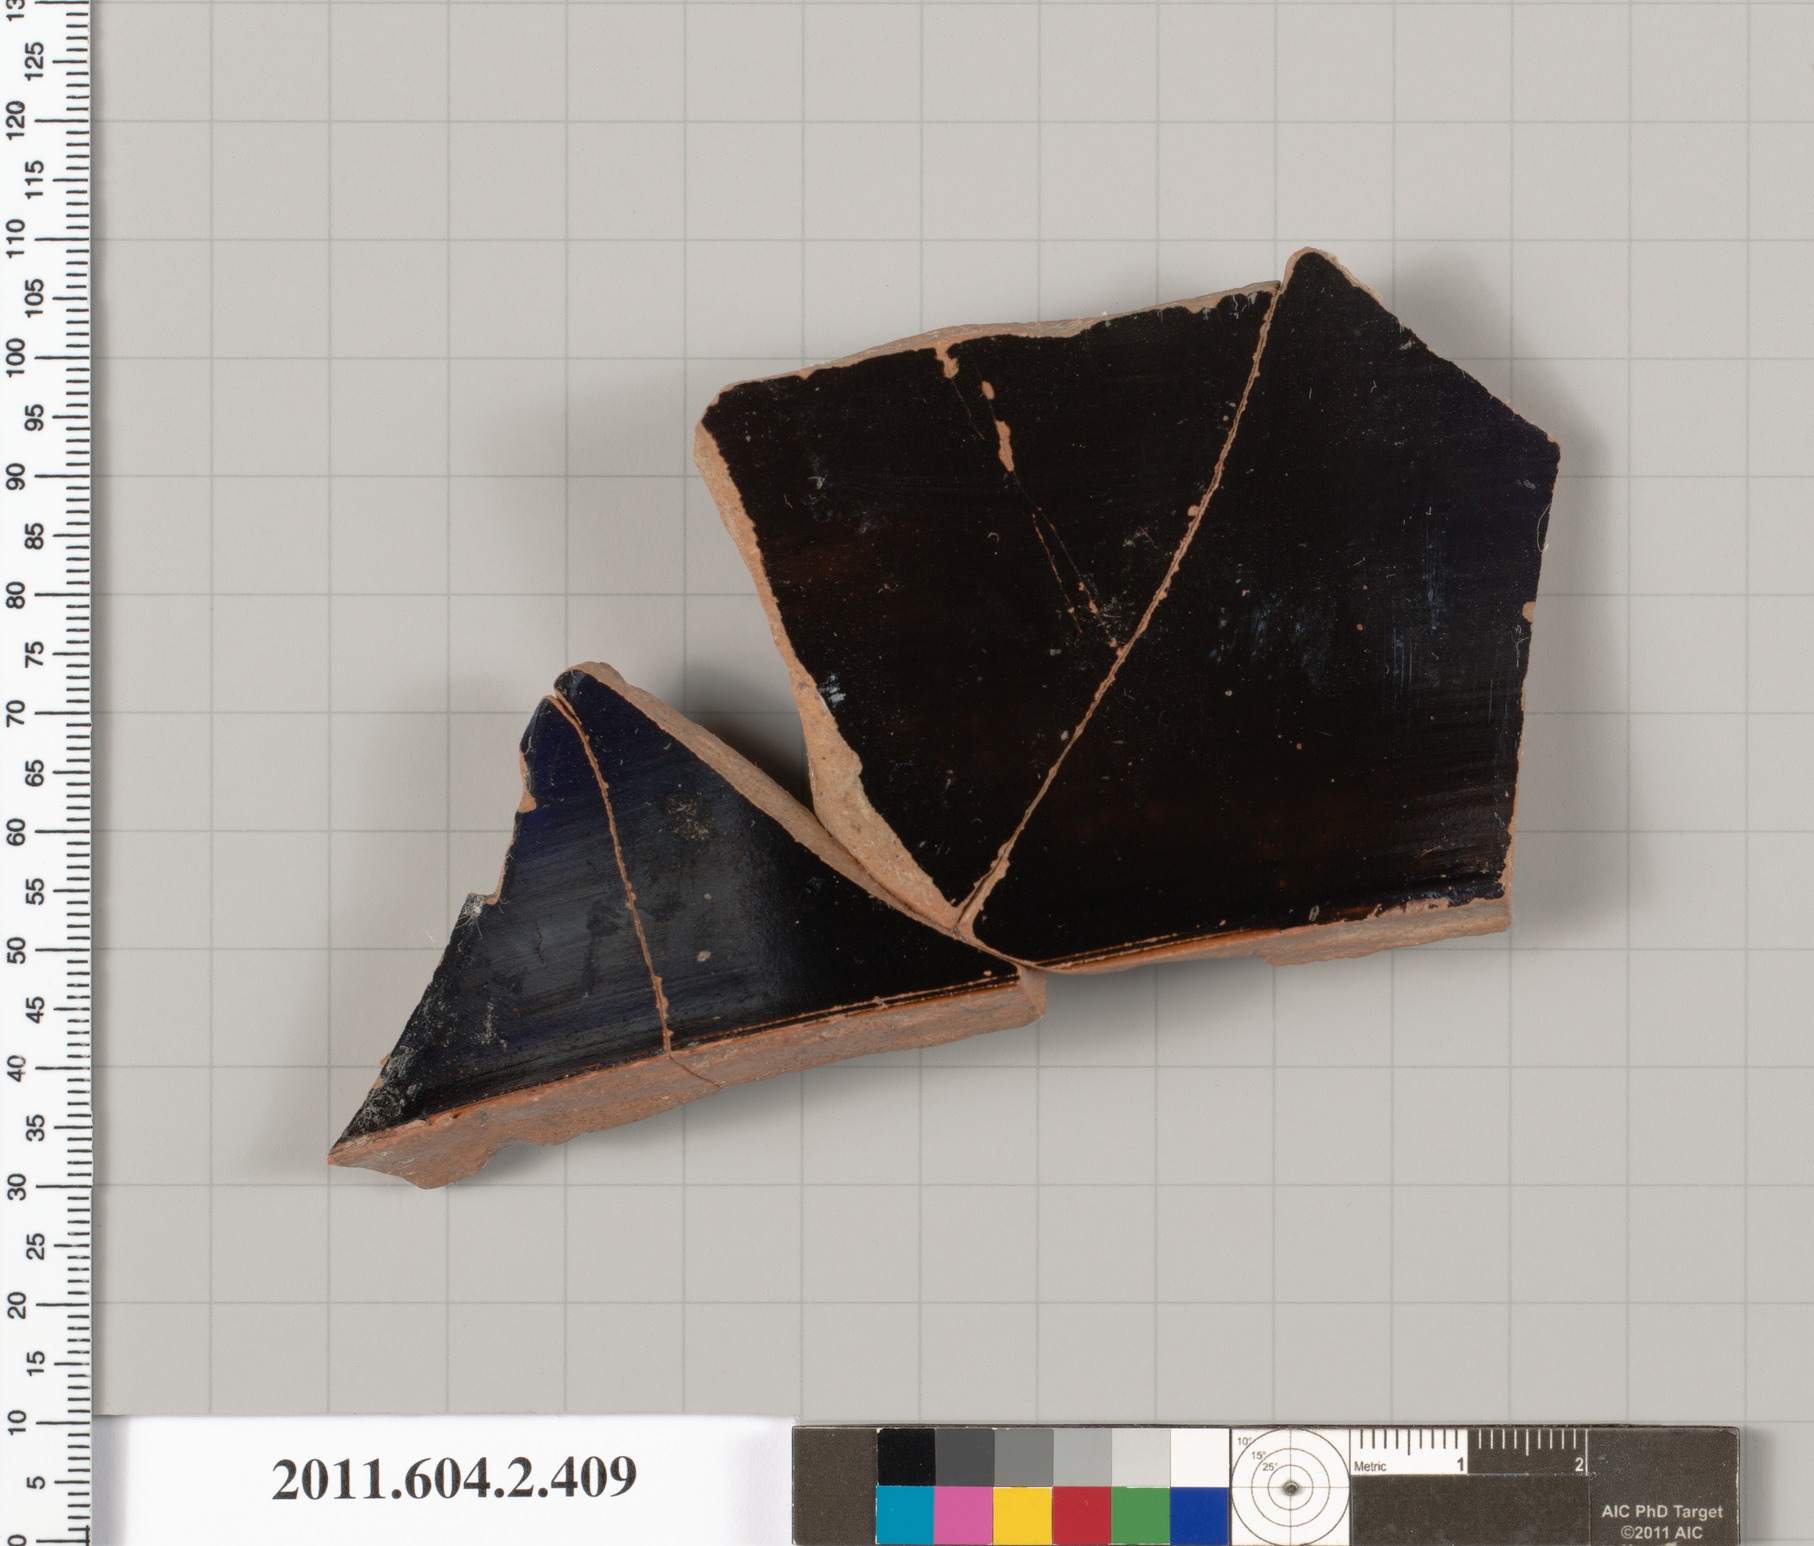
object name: column krater fragment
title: Terracotta fragment of a column-krater (bowl for mixing wine and water)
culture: greek, attic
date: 460-440 BCE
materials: terracotta